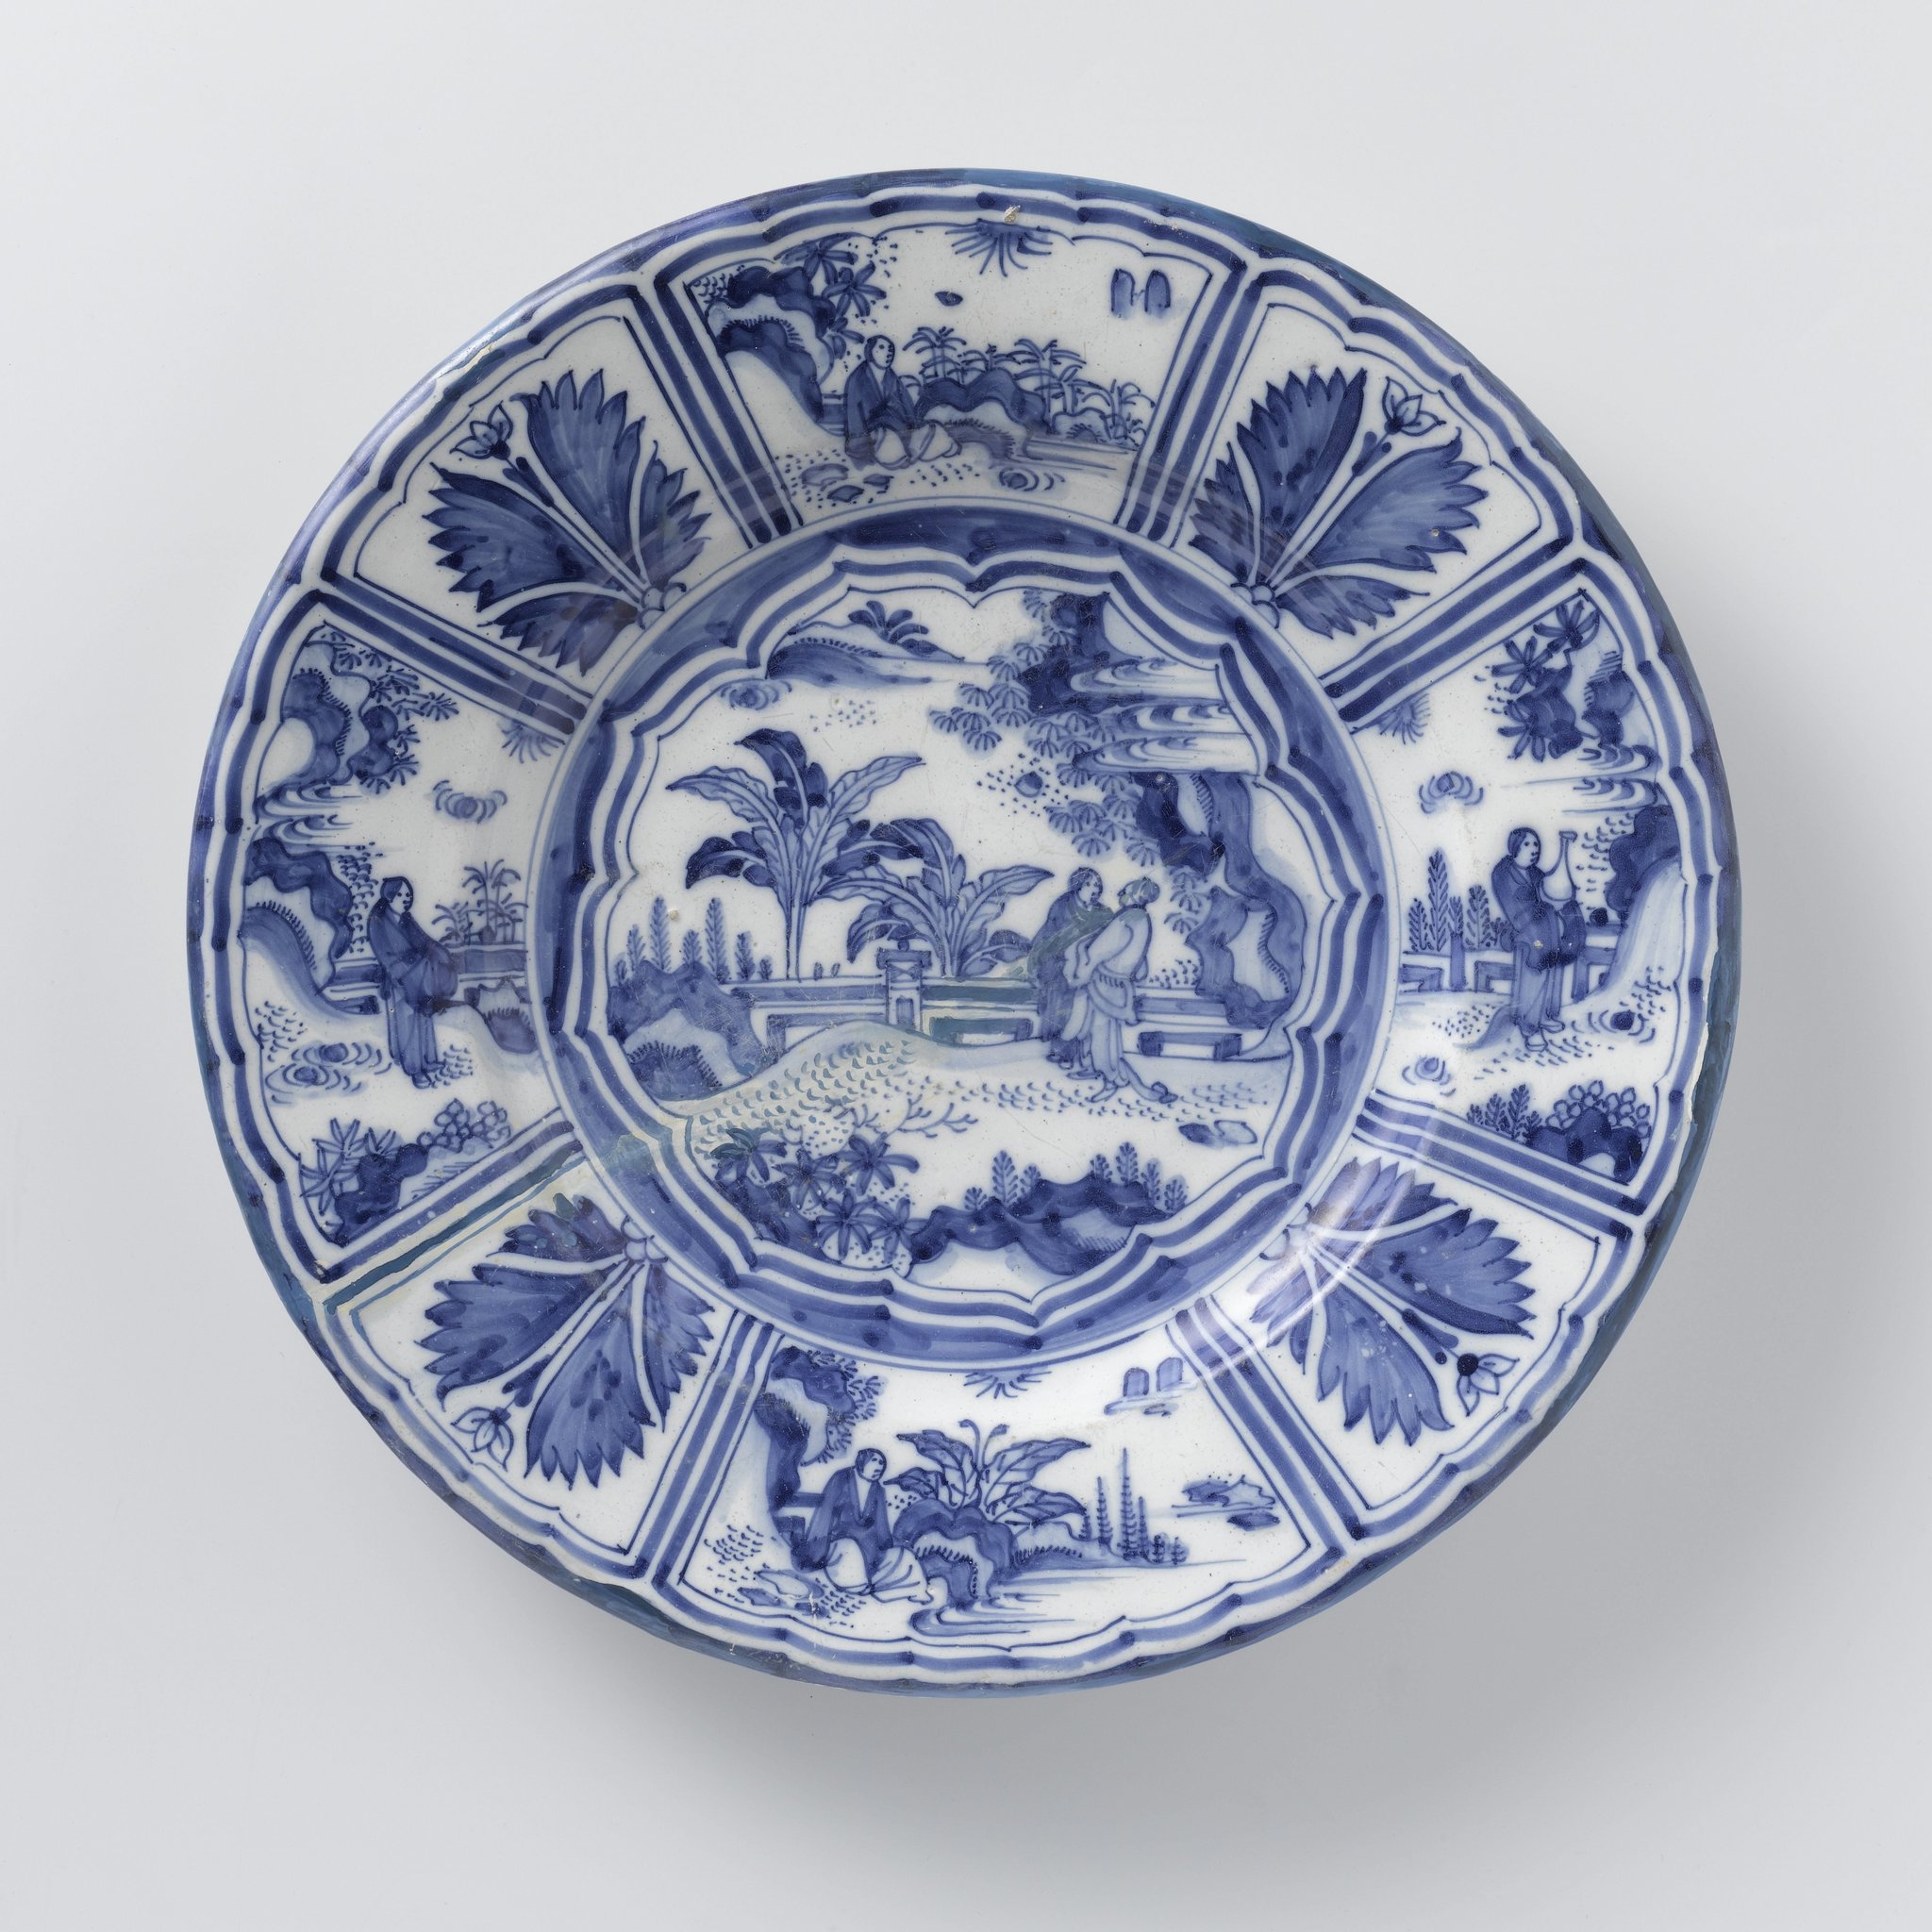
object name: platter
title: Schotel van faience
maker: Anonymous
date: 1650-1670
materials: earthenware, glaze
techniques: painted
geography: delft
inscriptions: mark: ‘rechthoek in perspectief met een cirkel erachter.’, inscription: ‘Her(?)/ 16 dec […]8[…]/ f 5,-’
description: Ronde schotel van blauw beschilderde faience. Op het plat is een landschap met twee figuren geschilderd. De rand is verdeeld in vier grote vakken en vier kleine vakken. In twee grote vakken is een staande figuur in een landschap geschilderd en in de andere twee vakken een zittende figuur. In de kleine vakken is een gestileerde bloem met vier bladeren geschilderd. Het bord is gemerkt.